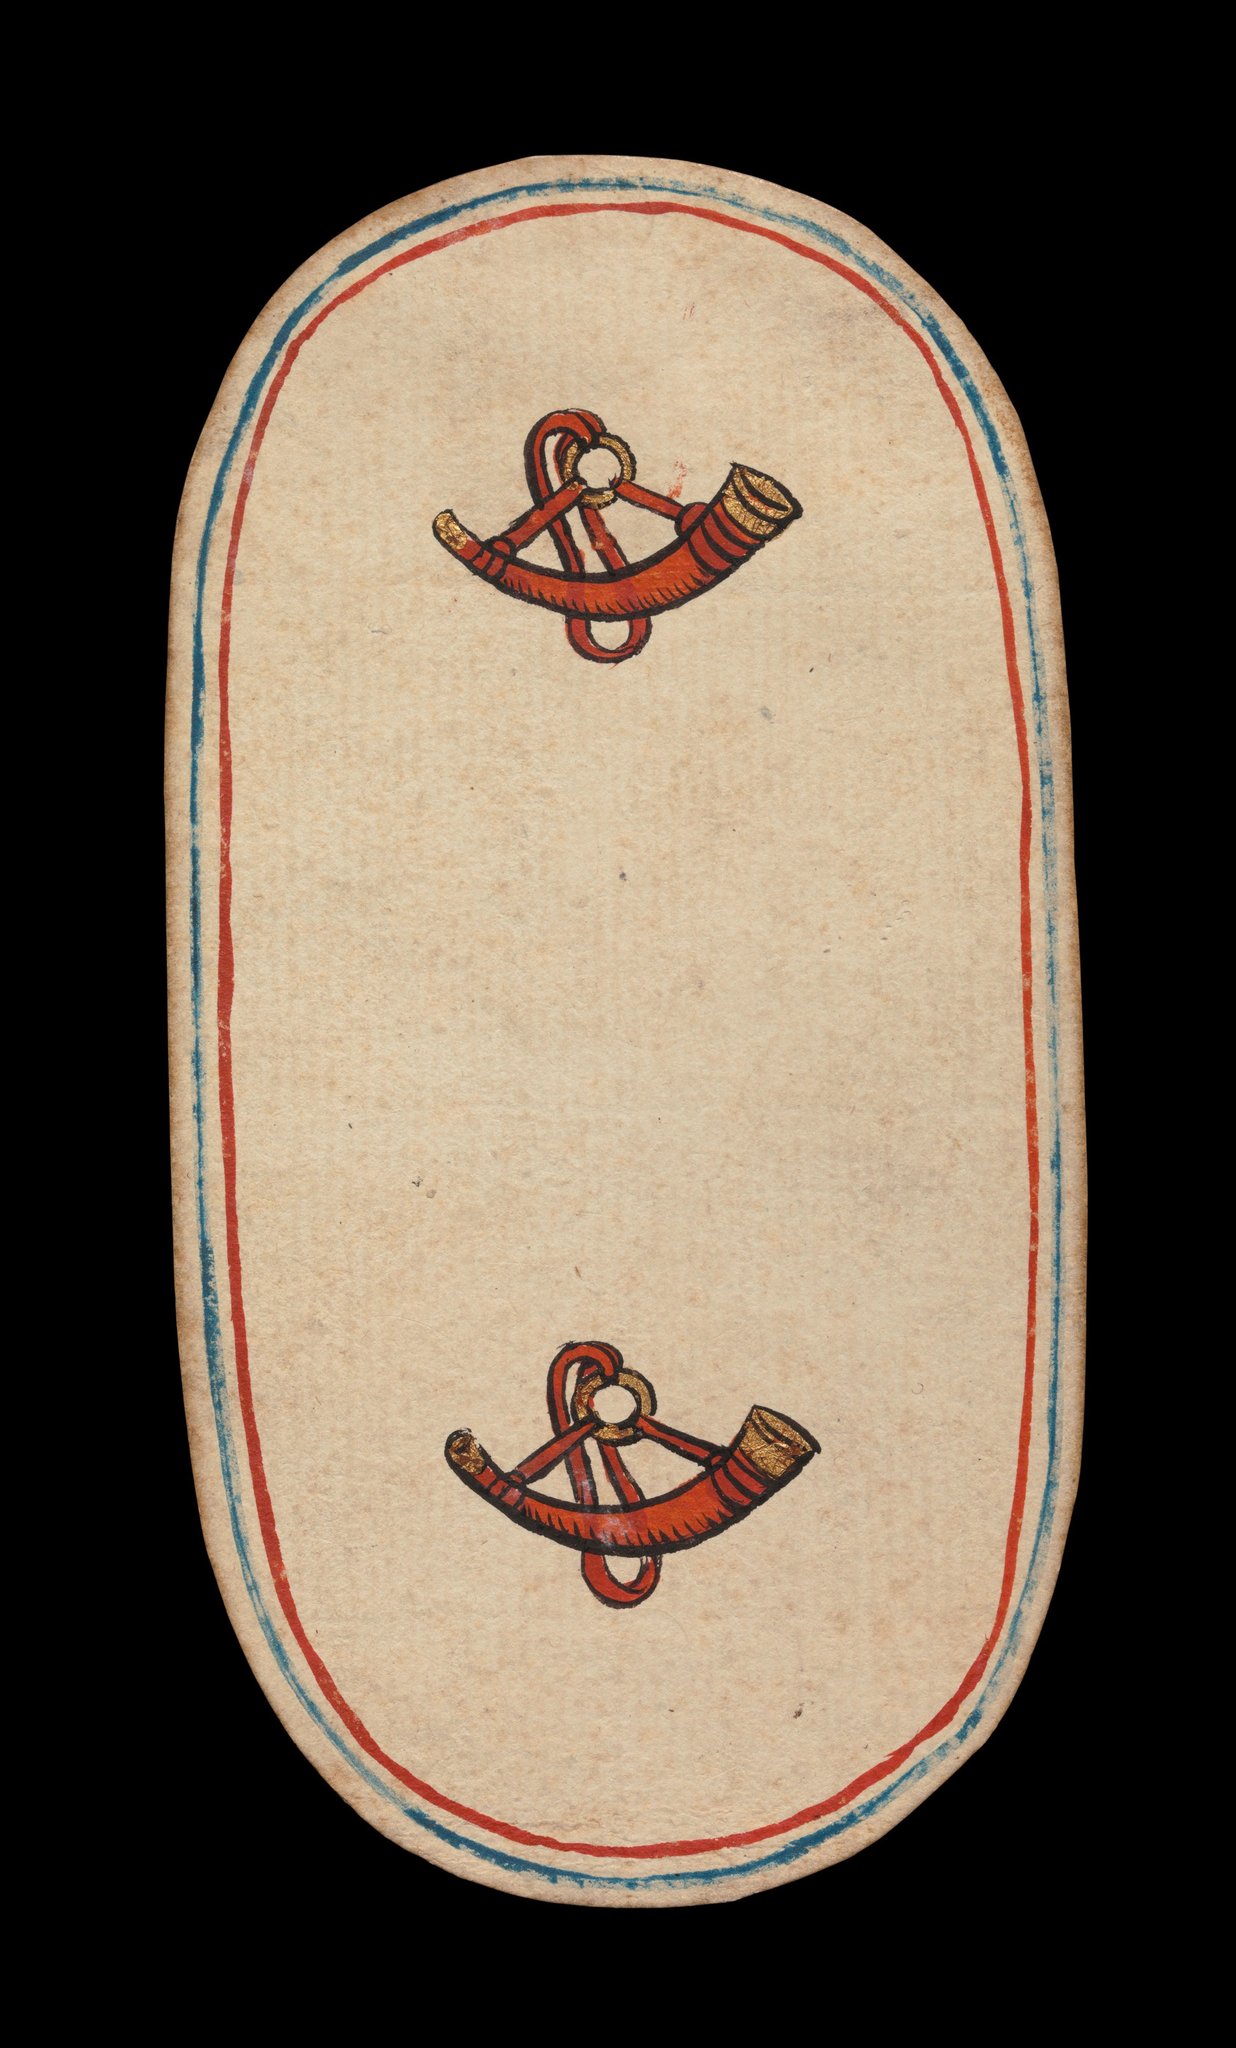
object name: playing card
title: 2 of Horns, from The Cloisters Playing Cards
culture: south netherlandish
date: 1475-1480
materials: glaze, gold, ink, paint, paper, silver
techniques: pen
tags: playing cards,horns,games